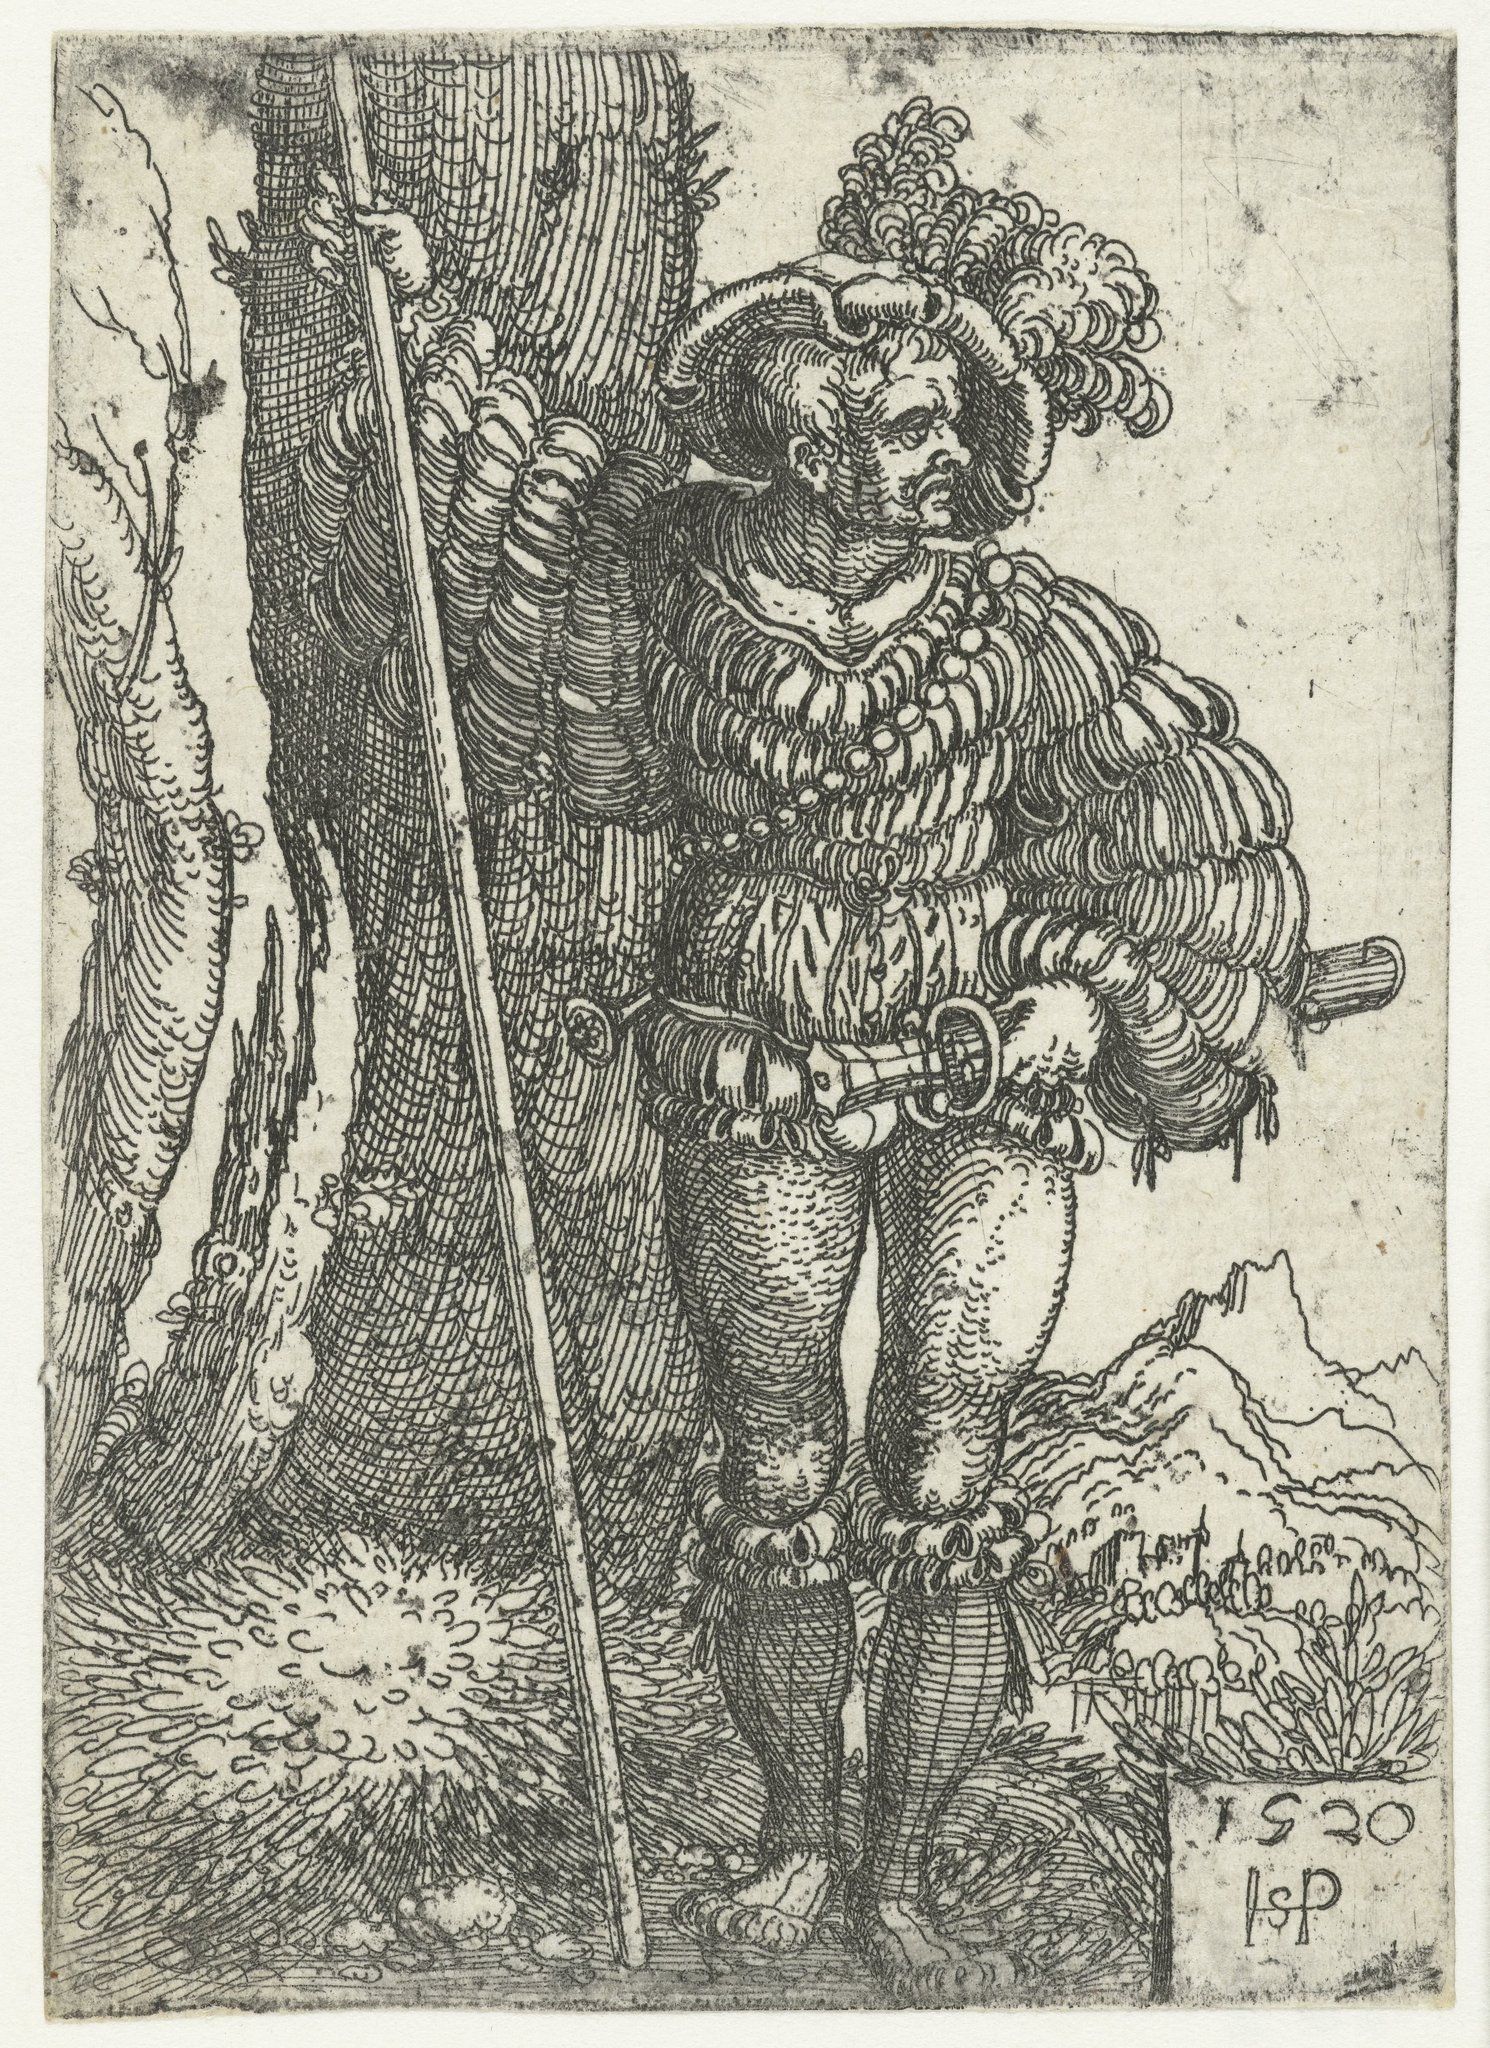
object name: print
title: Landsknecht staand bij een boom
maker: hans sebald beham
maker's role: designer, draughtsman, print maker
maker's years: 1500-1550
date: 1520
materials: paper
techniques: iron etching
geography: nuremberg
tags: private soldier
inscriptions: collector's mark: Lugt 2228a